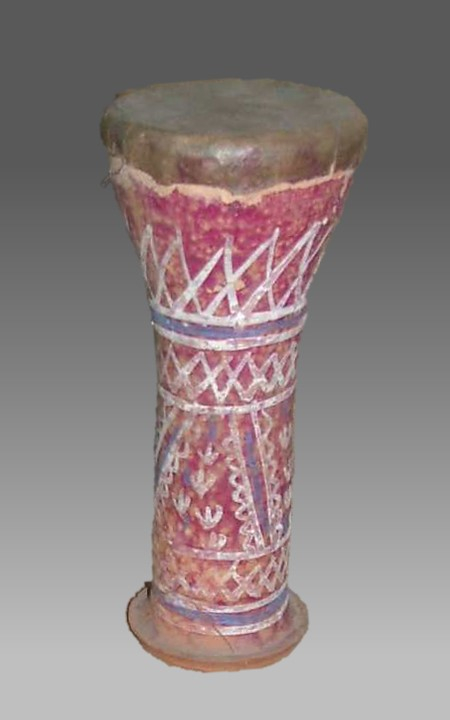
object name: t'arija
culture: moroccan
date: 1867-1900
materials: clay, skin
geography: morocco